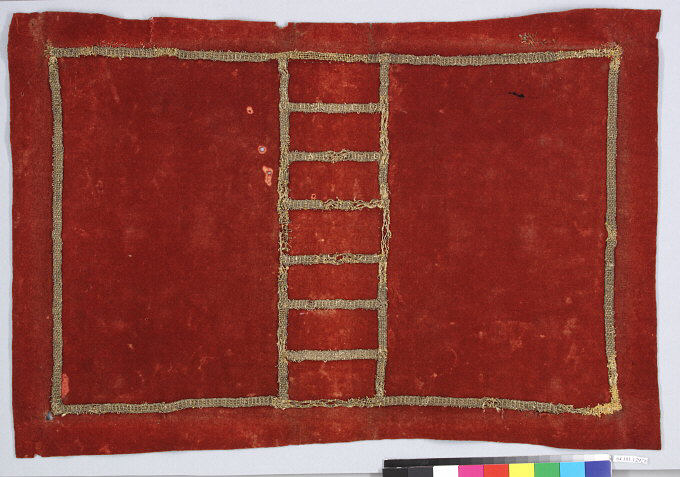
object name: book cover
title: Cover for bookbinding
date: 1601-1700